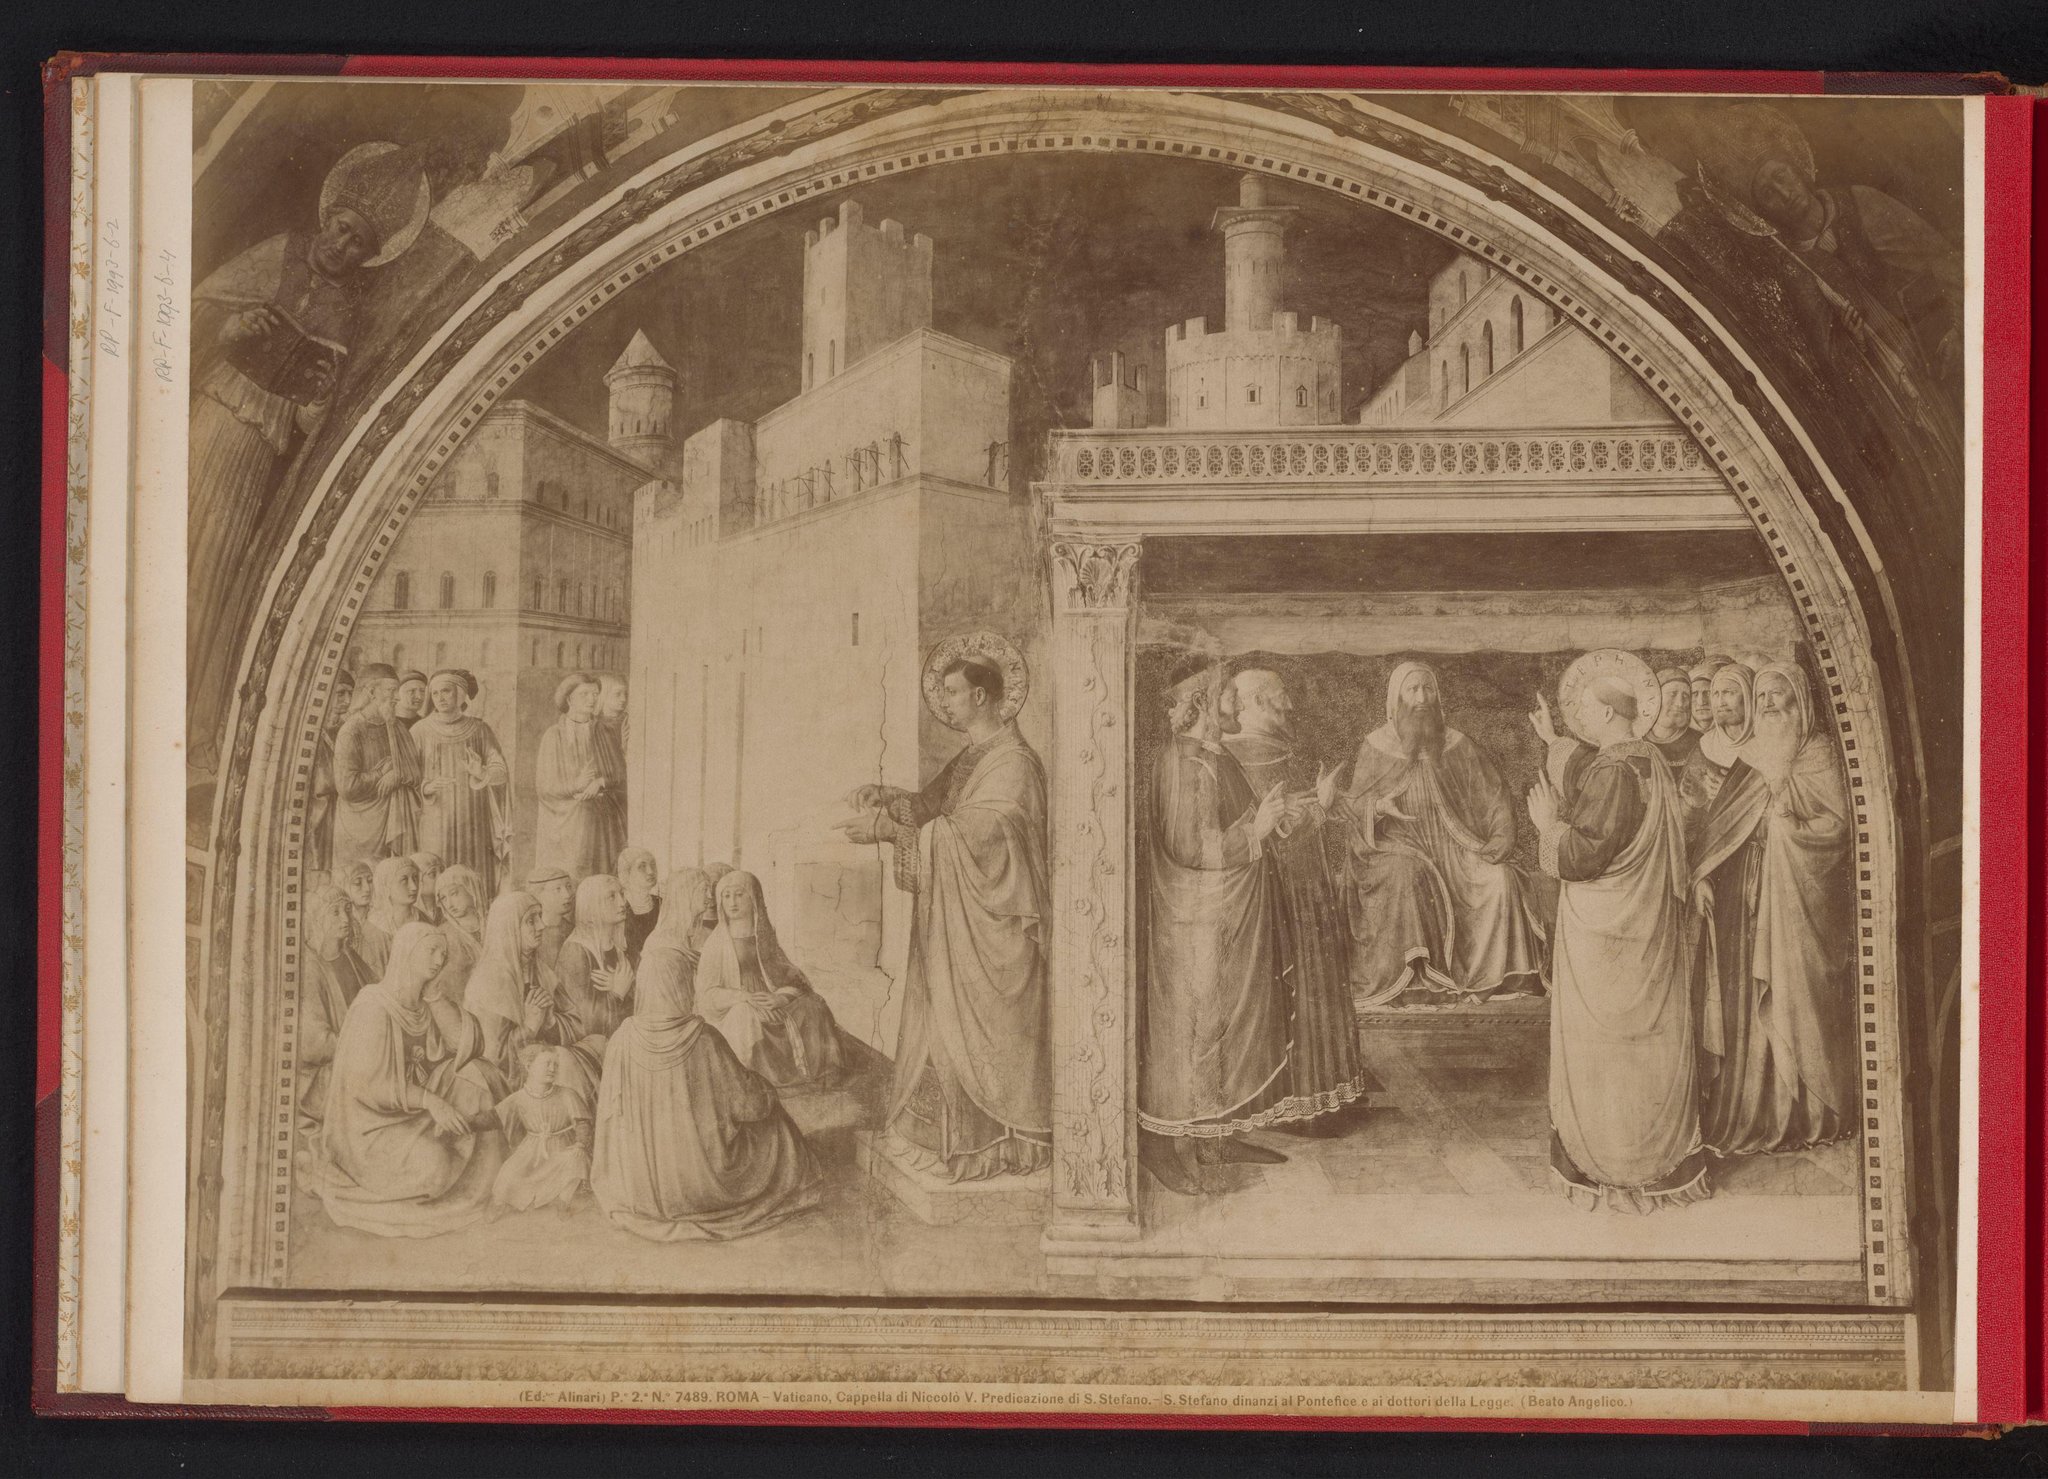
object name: reproduction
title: Fotoreproductie van fresco Prediking van de heilige Stefanus en De heilige Stefano voor de hogepriester en de wetsgeleerden, door Fra Angelico, Kapel van Nicolaas V, Vaticaan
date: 1860-1900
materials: paper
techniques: albumen print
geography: chapel of nicholas v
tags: the deacon and (proto)martyr stephen; possible attributes: censer, stones, picture, painting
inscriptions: inscription: ‘(ed.ne Alinari) P.e 2.a N.o 7489 ROMA - Vaticano, Capella di Niccolò V. Predicazione di S. Stefano. - S. Stefano dinanzi al Pontefice e ai dottori della Legge. (Beato Angelico.)’